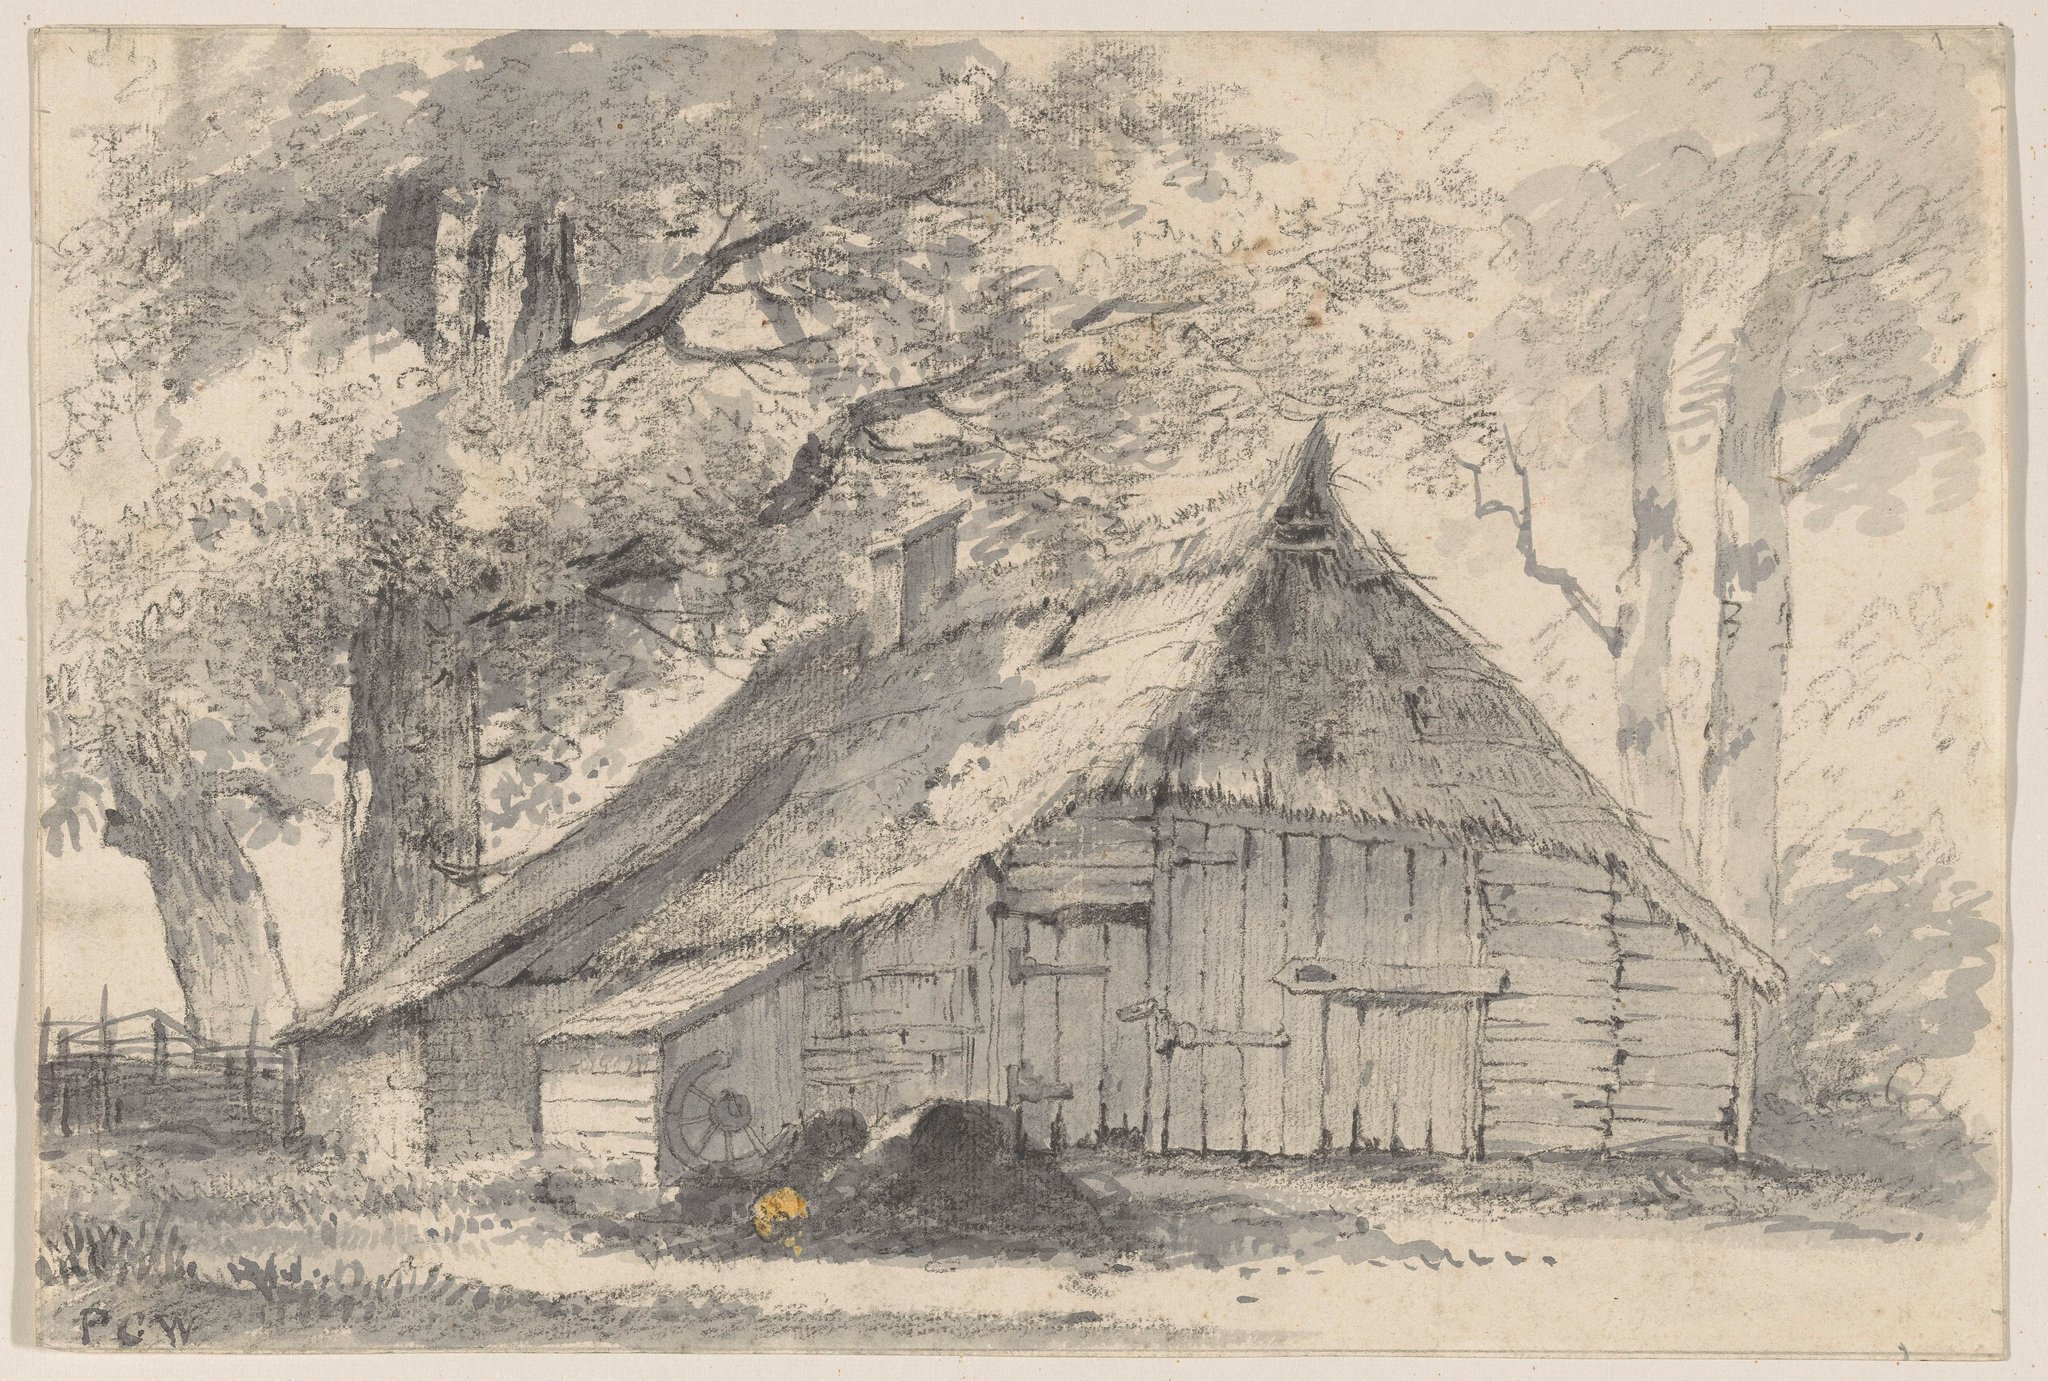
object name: drawing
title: Schaapskooi en schuur te Gelderland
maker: george pieter westenberg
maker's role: draughtsman, painter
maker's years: 1791-1873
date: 1816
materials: chalk, paper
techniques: brush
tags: barn, gelderland